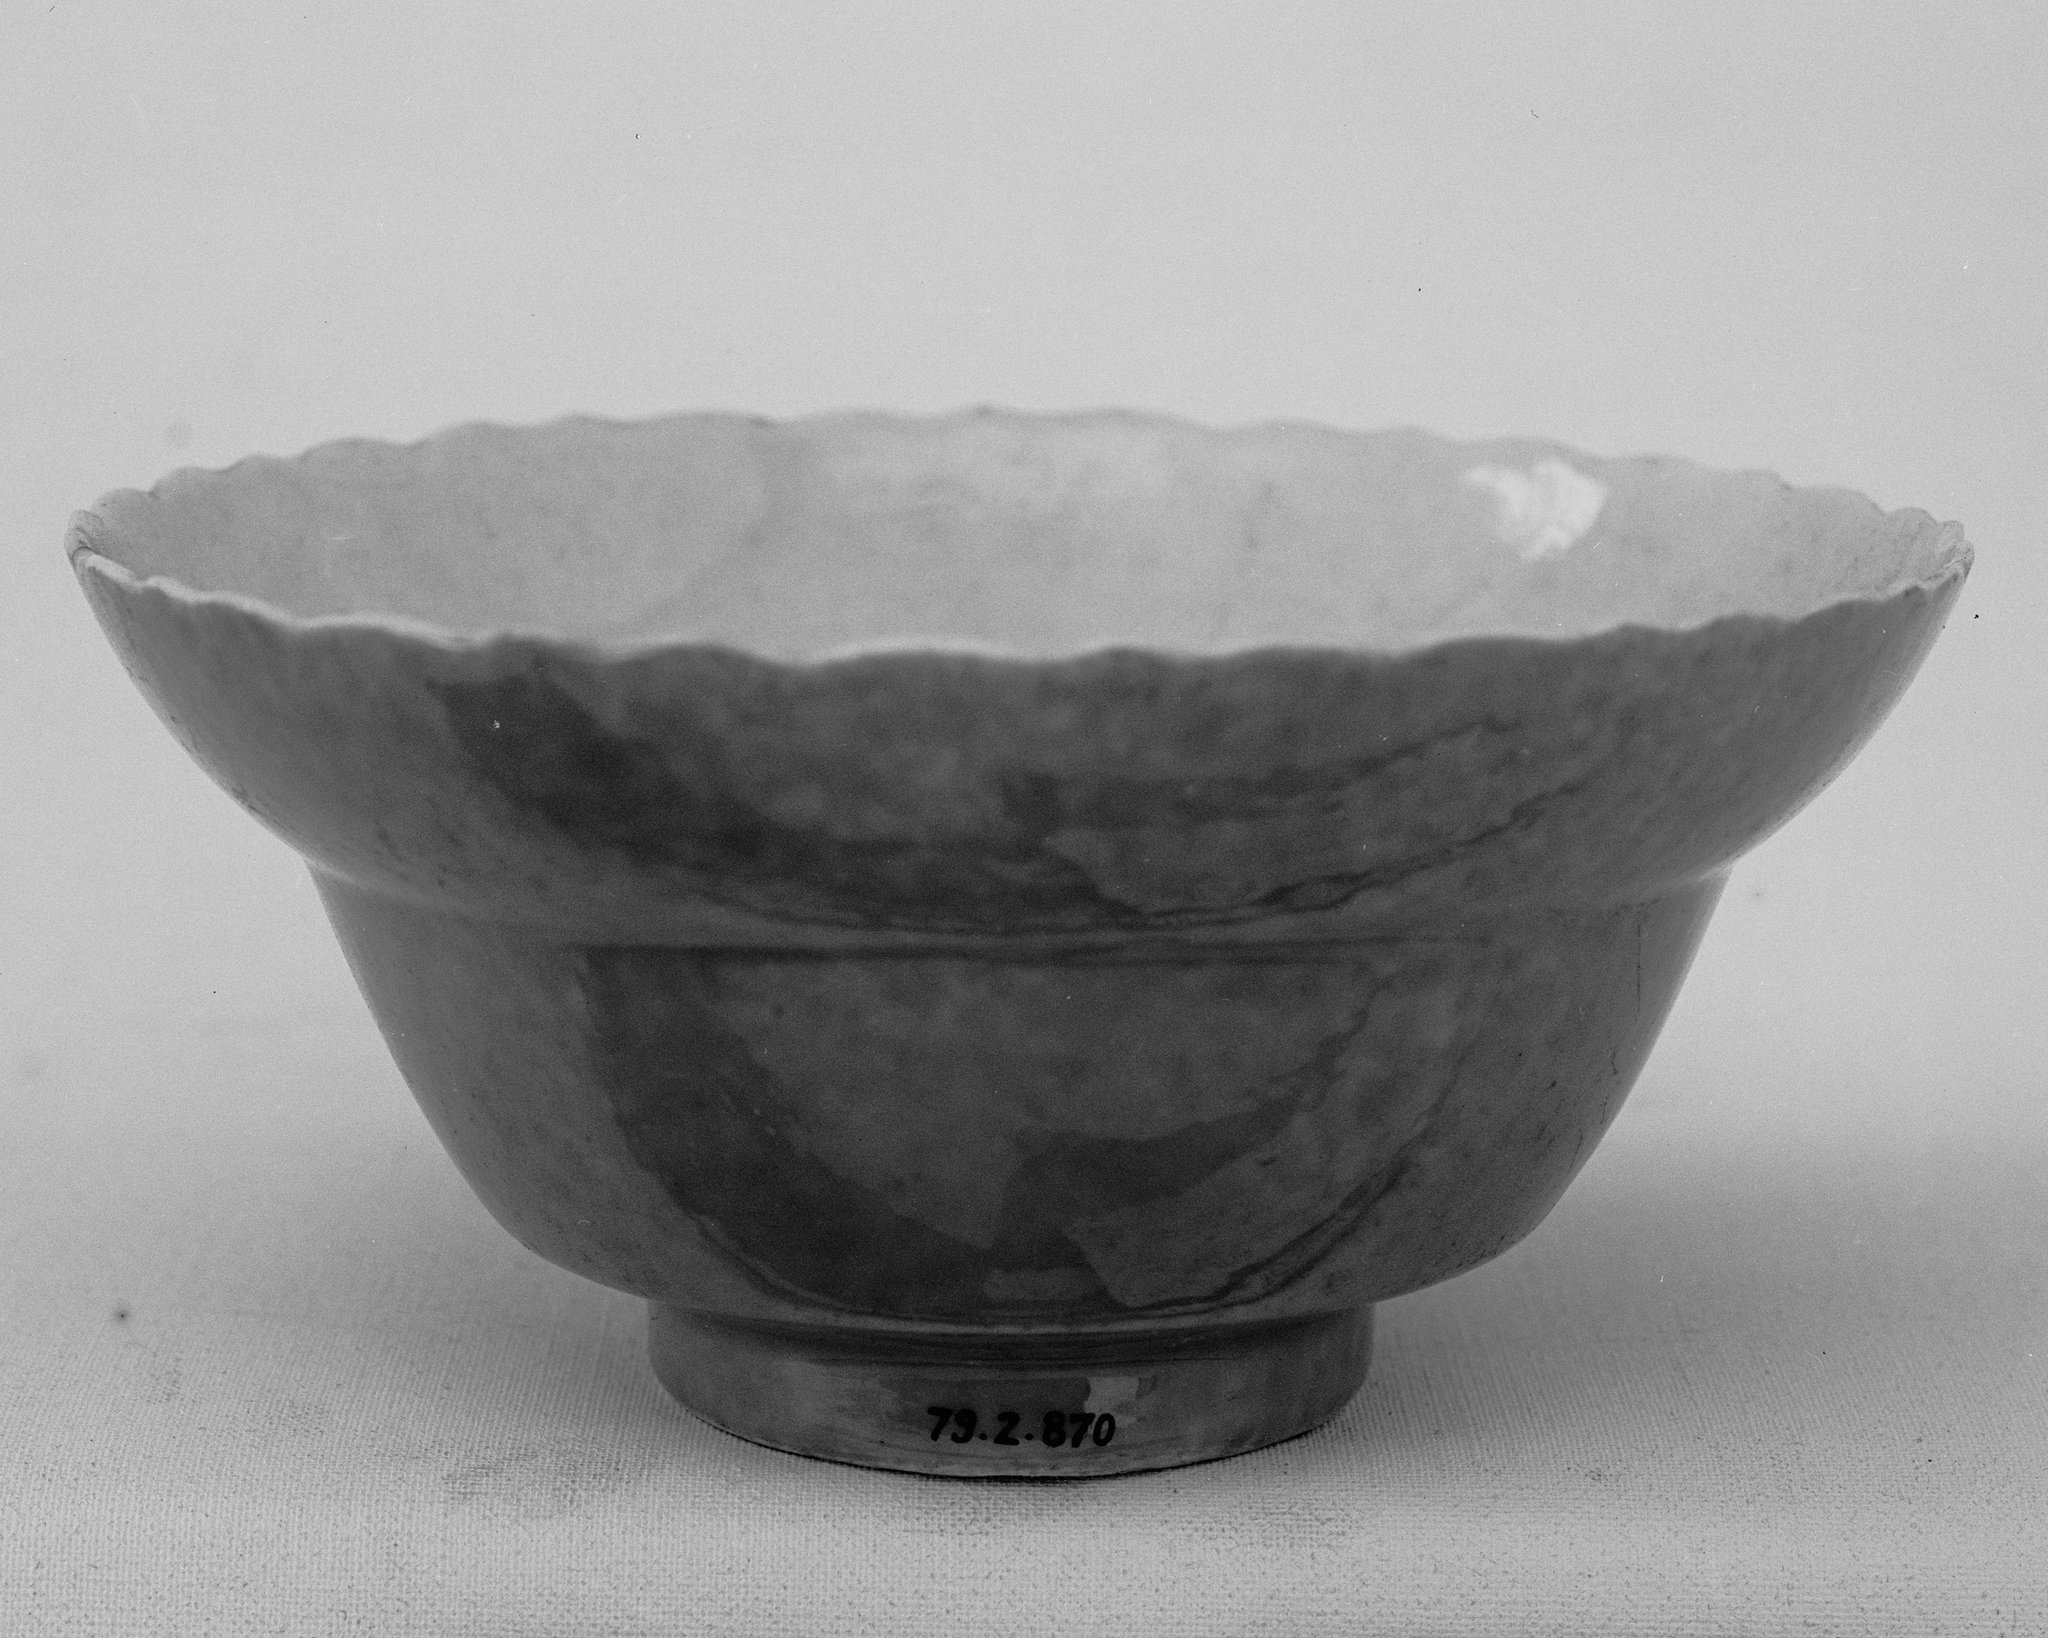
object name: bowl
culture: chinese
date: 1767-1800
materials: glaze, porcelain